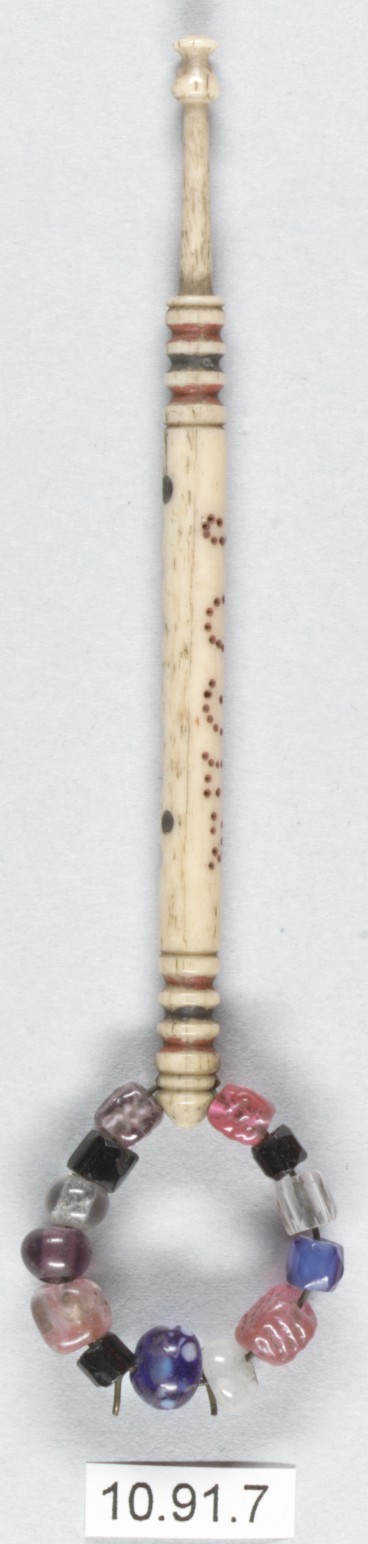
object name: bobbin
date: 1801-1900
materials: bone